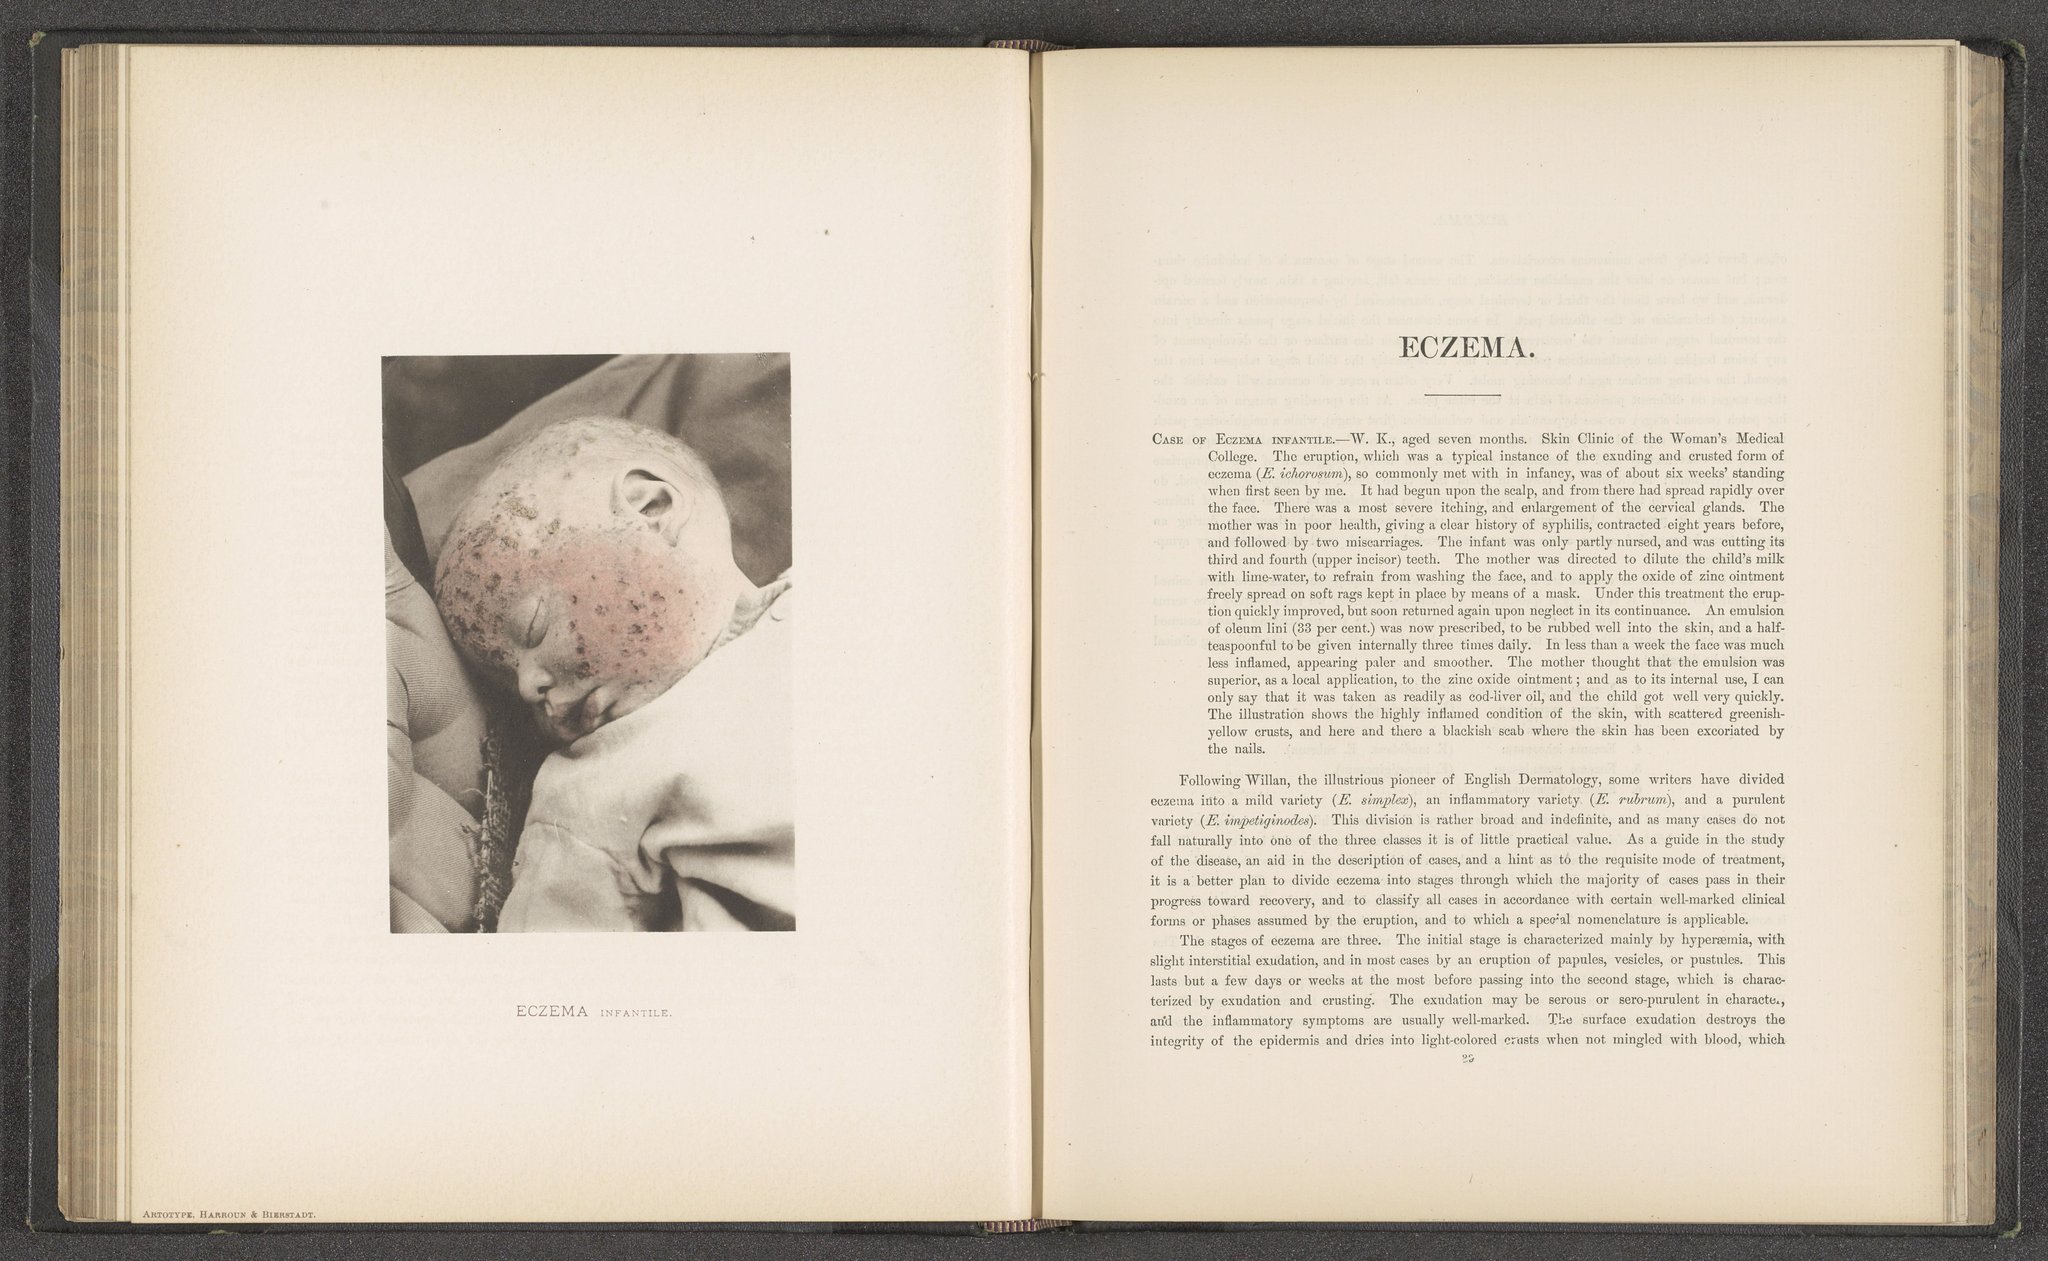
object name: photomechanical print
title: Eczema infantile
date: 1870-1881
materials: paper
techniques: photograph, hand coloring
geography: new york city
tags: skin and venereal diseases, infant, baby